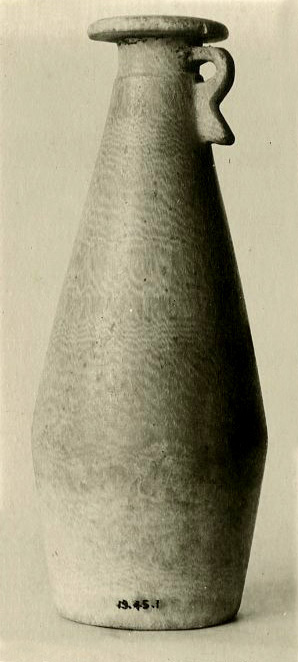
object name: jug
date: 522-30 BCE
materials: stone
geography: egypt